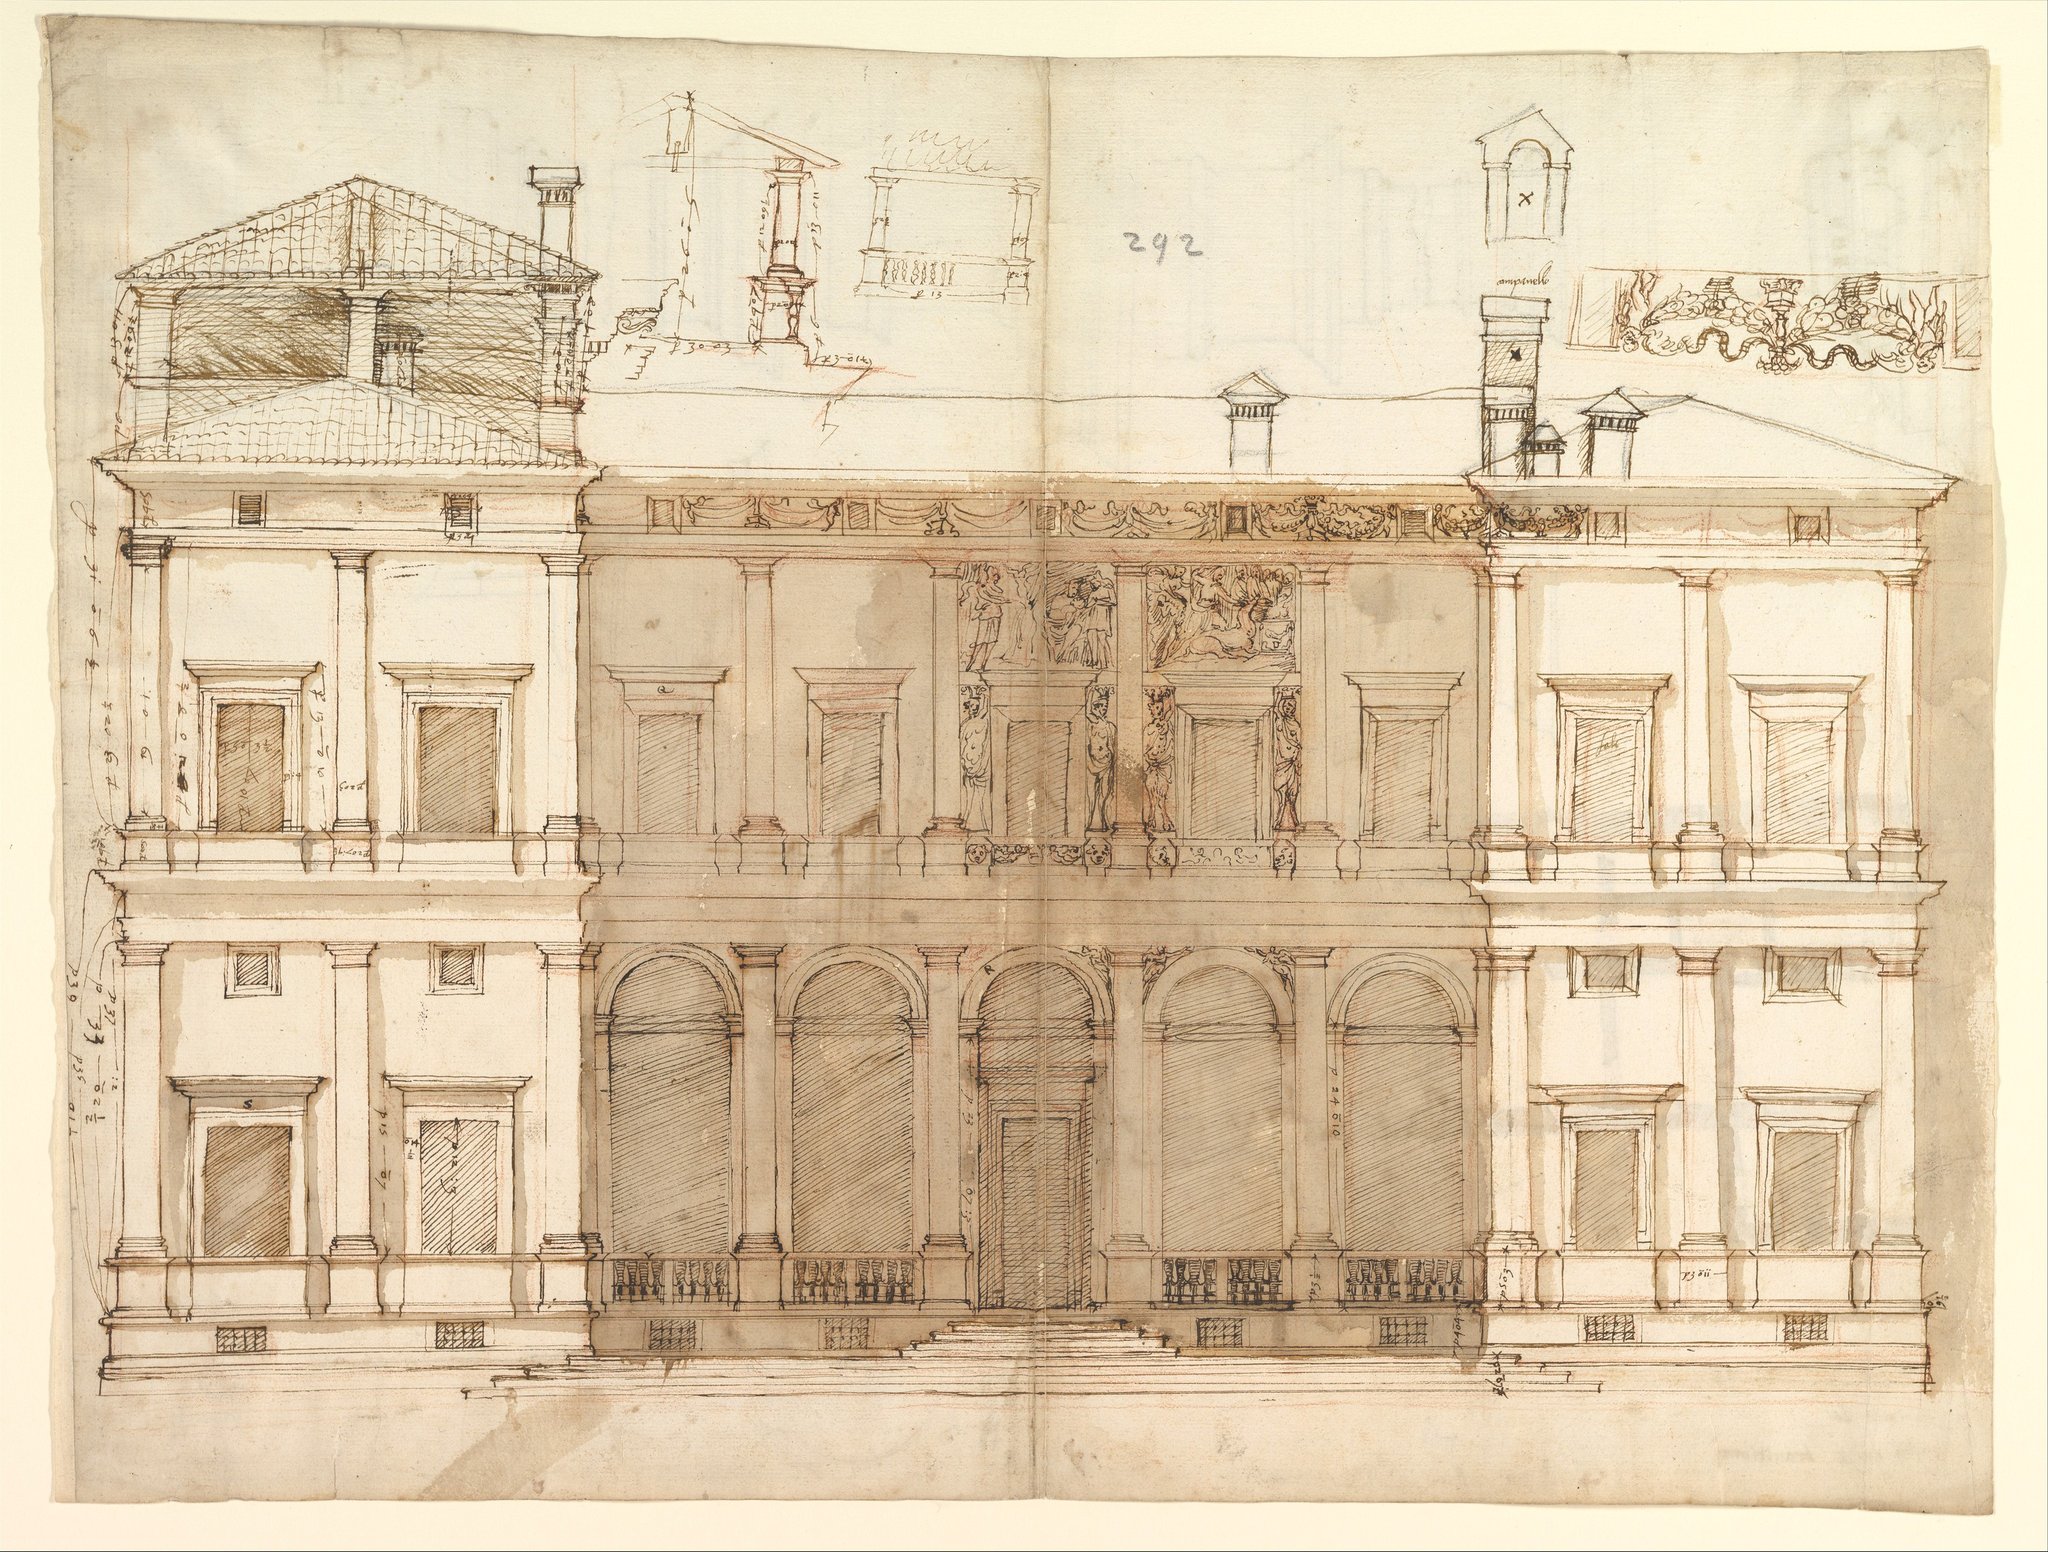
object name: drawing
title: Villa of Agostino Chigi (La Farnesina), Rome, north façade, with ornamental detailing (recto); Villa of Agostino Chigi (La Farnesina), Rome, plan and moulding profiles (verso)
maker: anonymous, french, 16th century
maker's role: draftsman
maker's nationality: french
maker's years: 1500-1600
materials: chalk, ink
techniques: incising, pen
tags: architecture,buildings